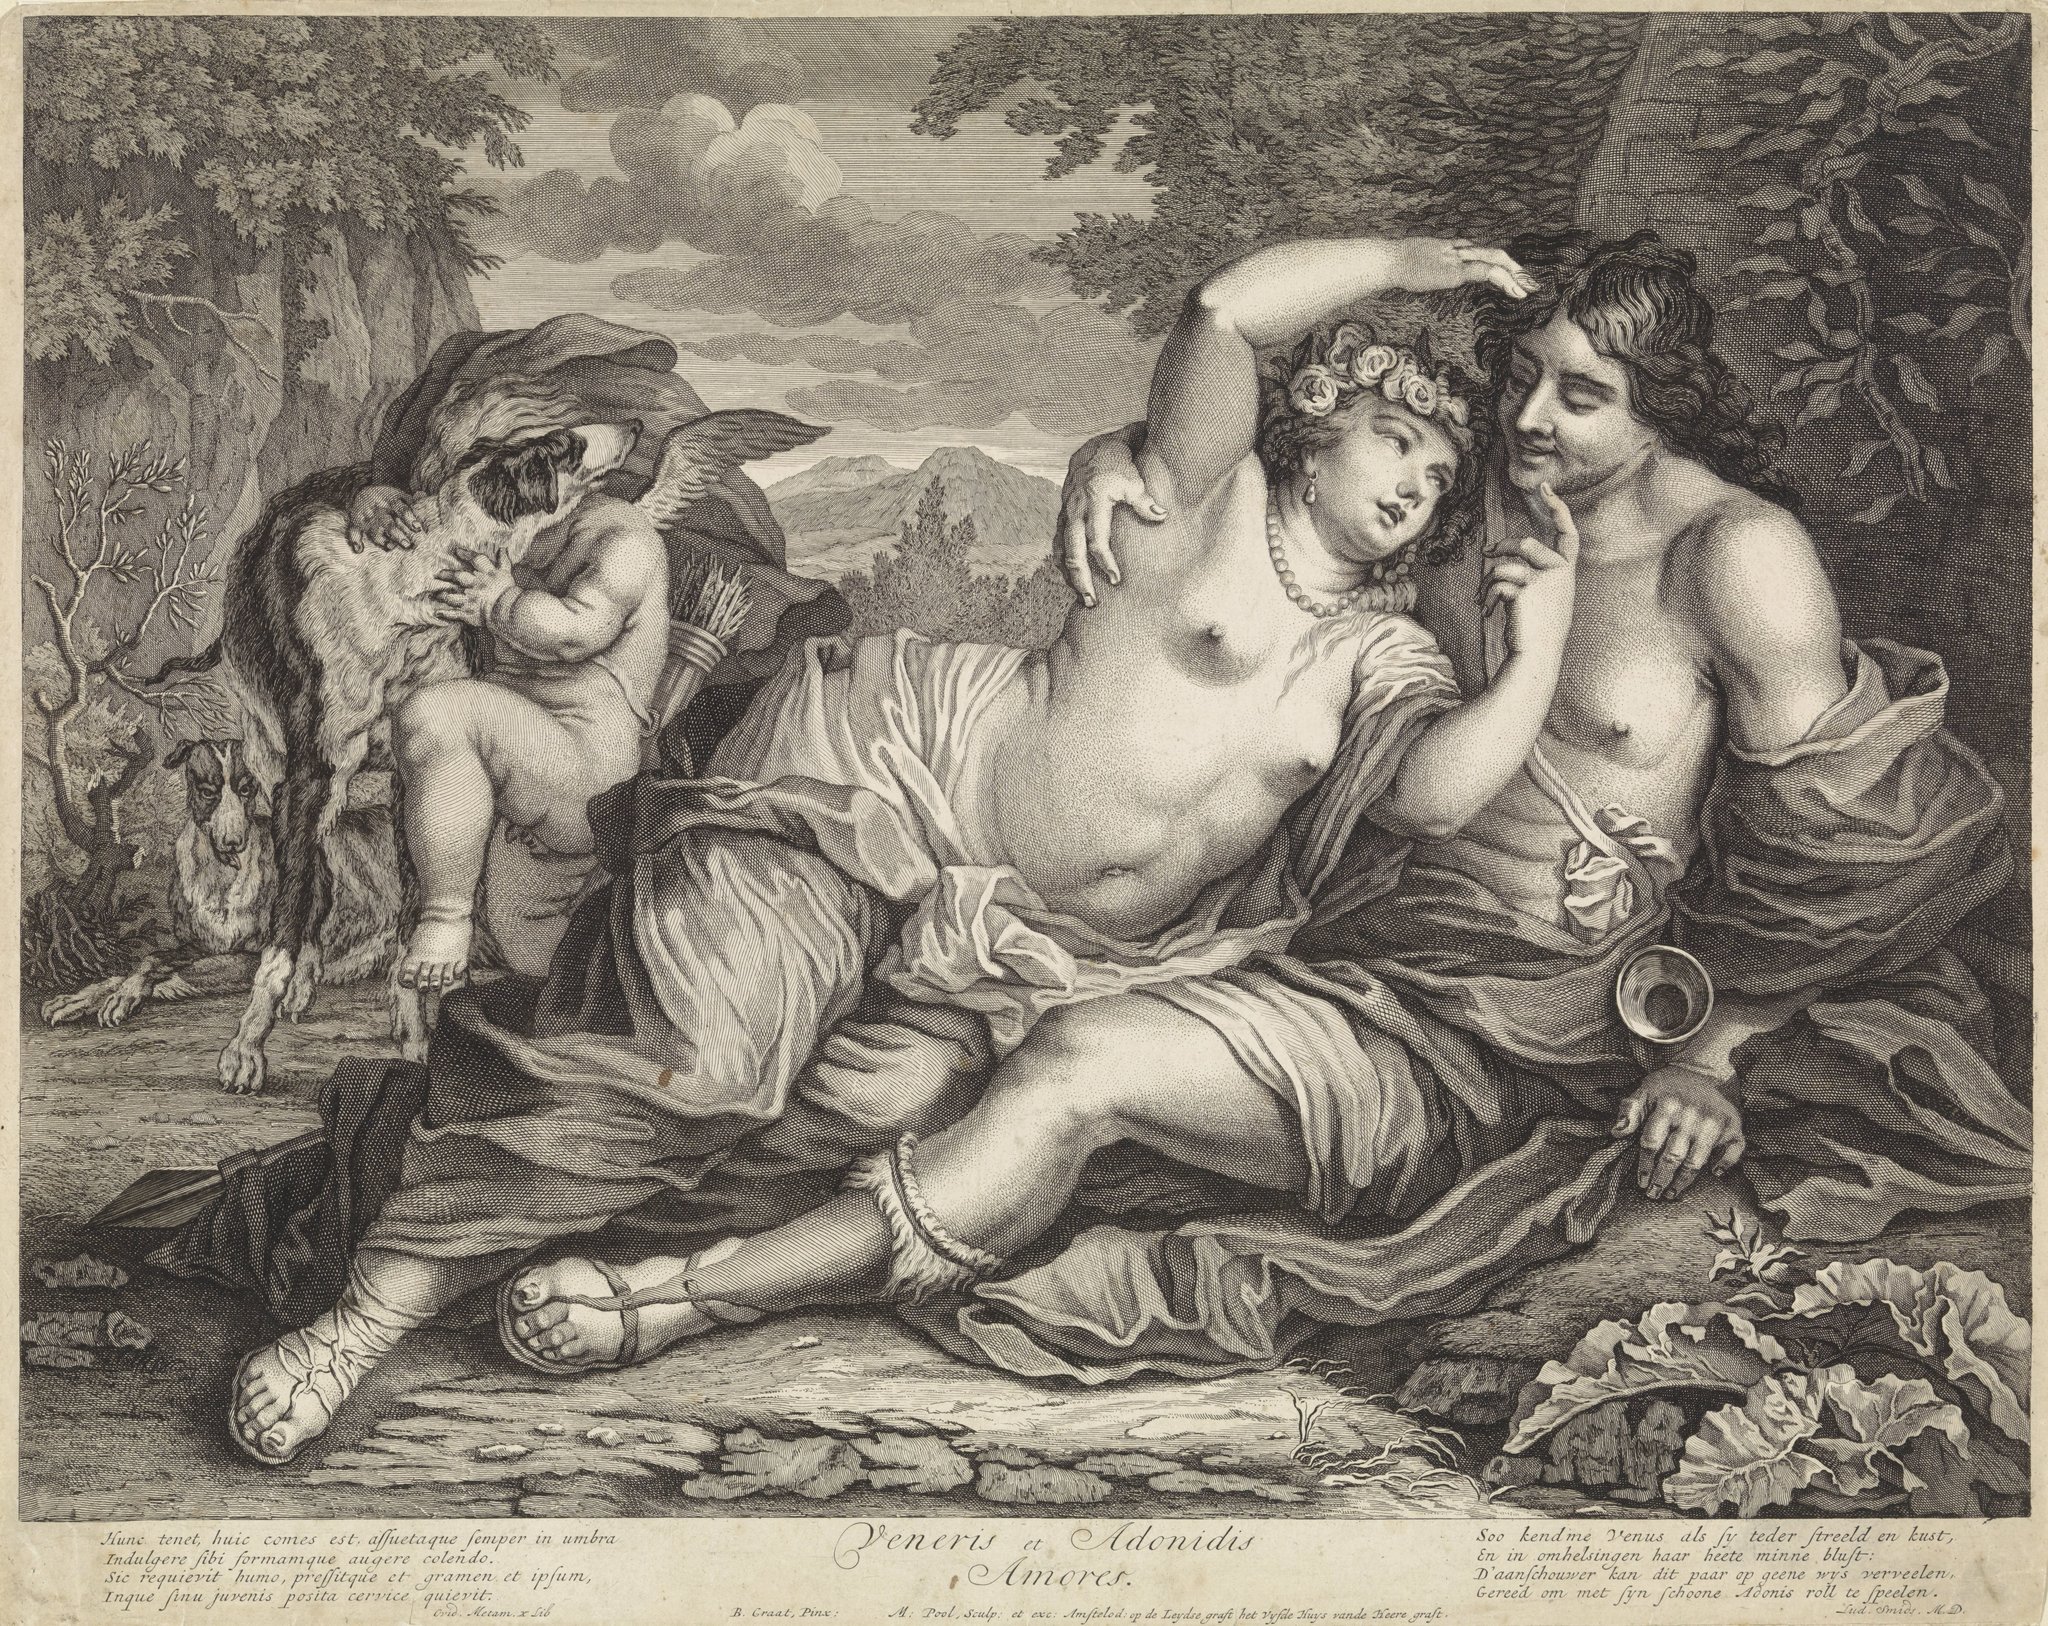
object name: print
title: Venus and Adonis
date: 1696-1727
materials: paper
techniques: engraving, etching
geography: amsterdam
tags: venus and adonis as lovers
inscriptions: collector's mark: Lugt 240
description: Landschap met Venus en Adonis. De godin ligt in de armen van Adonis en kijkt verliefd naar hem op. Ze wil niet dat haar geliefde gaat jagen. De jonge Adonis heeft zijn jachthoorn echter al onder de arm, en zijn pijl ligt aan hun voeten. Links Amor die speelt met de jachthonden van Adonis. In de marge een vierregelig gedicht in het Latijn en in het Nederlands.